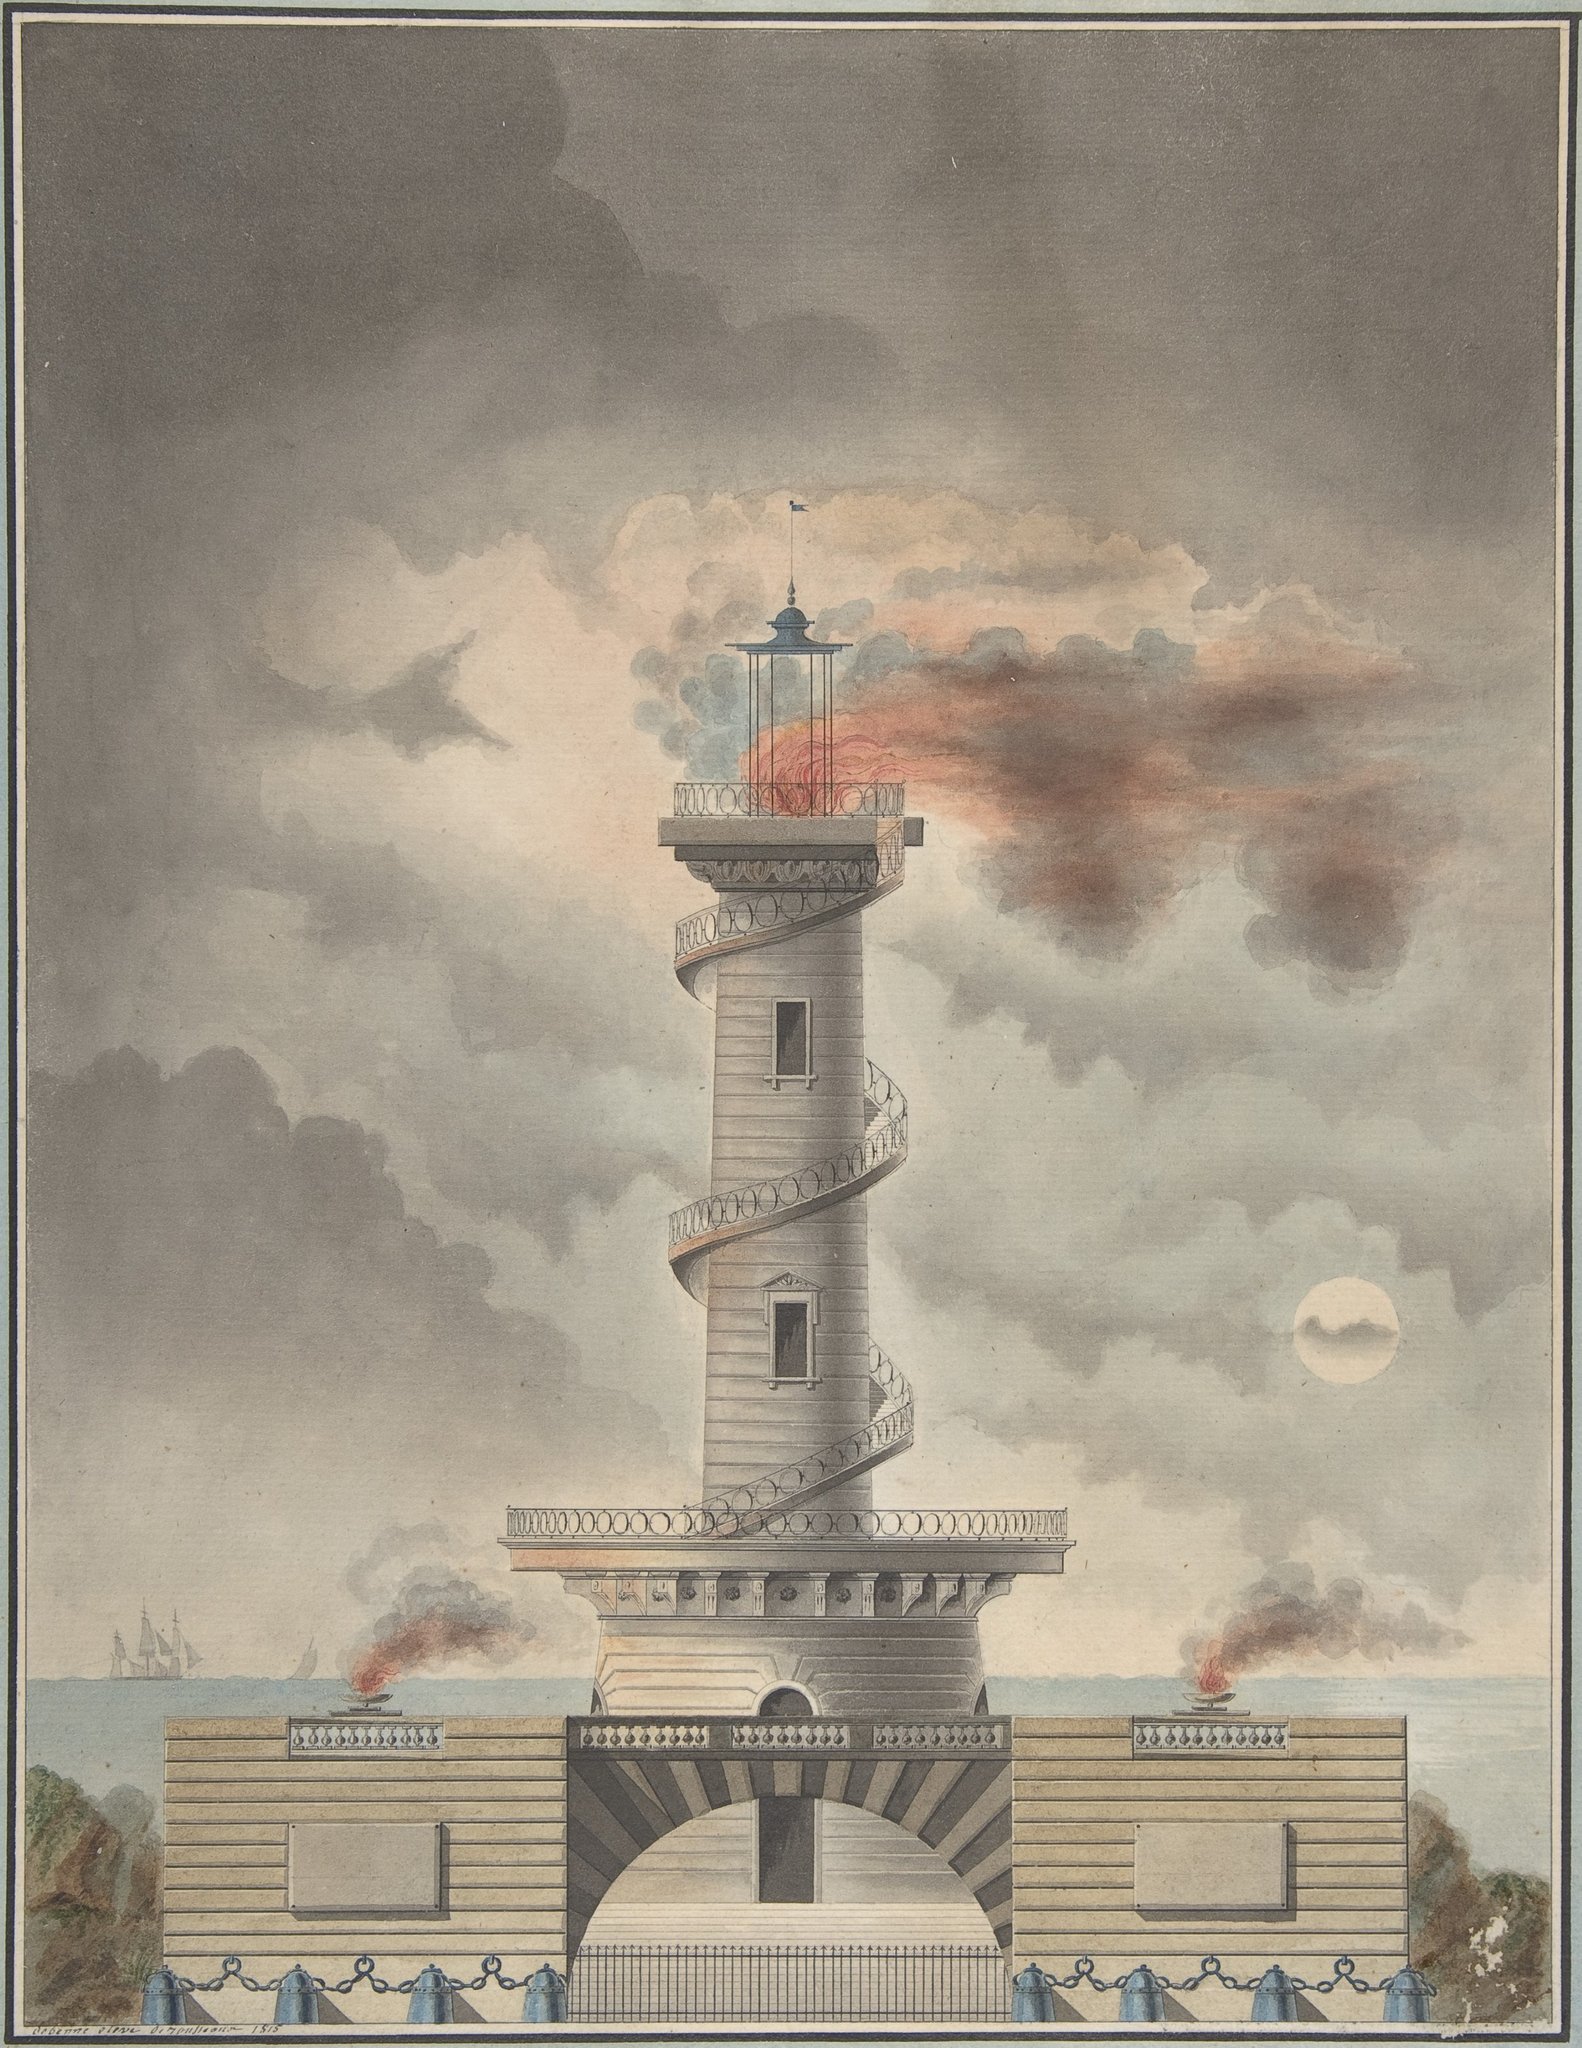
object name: drawing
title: Design for a Lighthouse (Margate?)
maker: debenne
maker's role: artist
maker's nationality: french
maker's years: 1815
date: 1815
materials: ink, watercolor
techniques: pen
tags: lighthouses